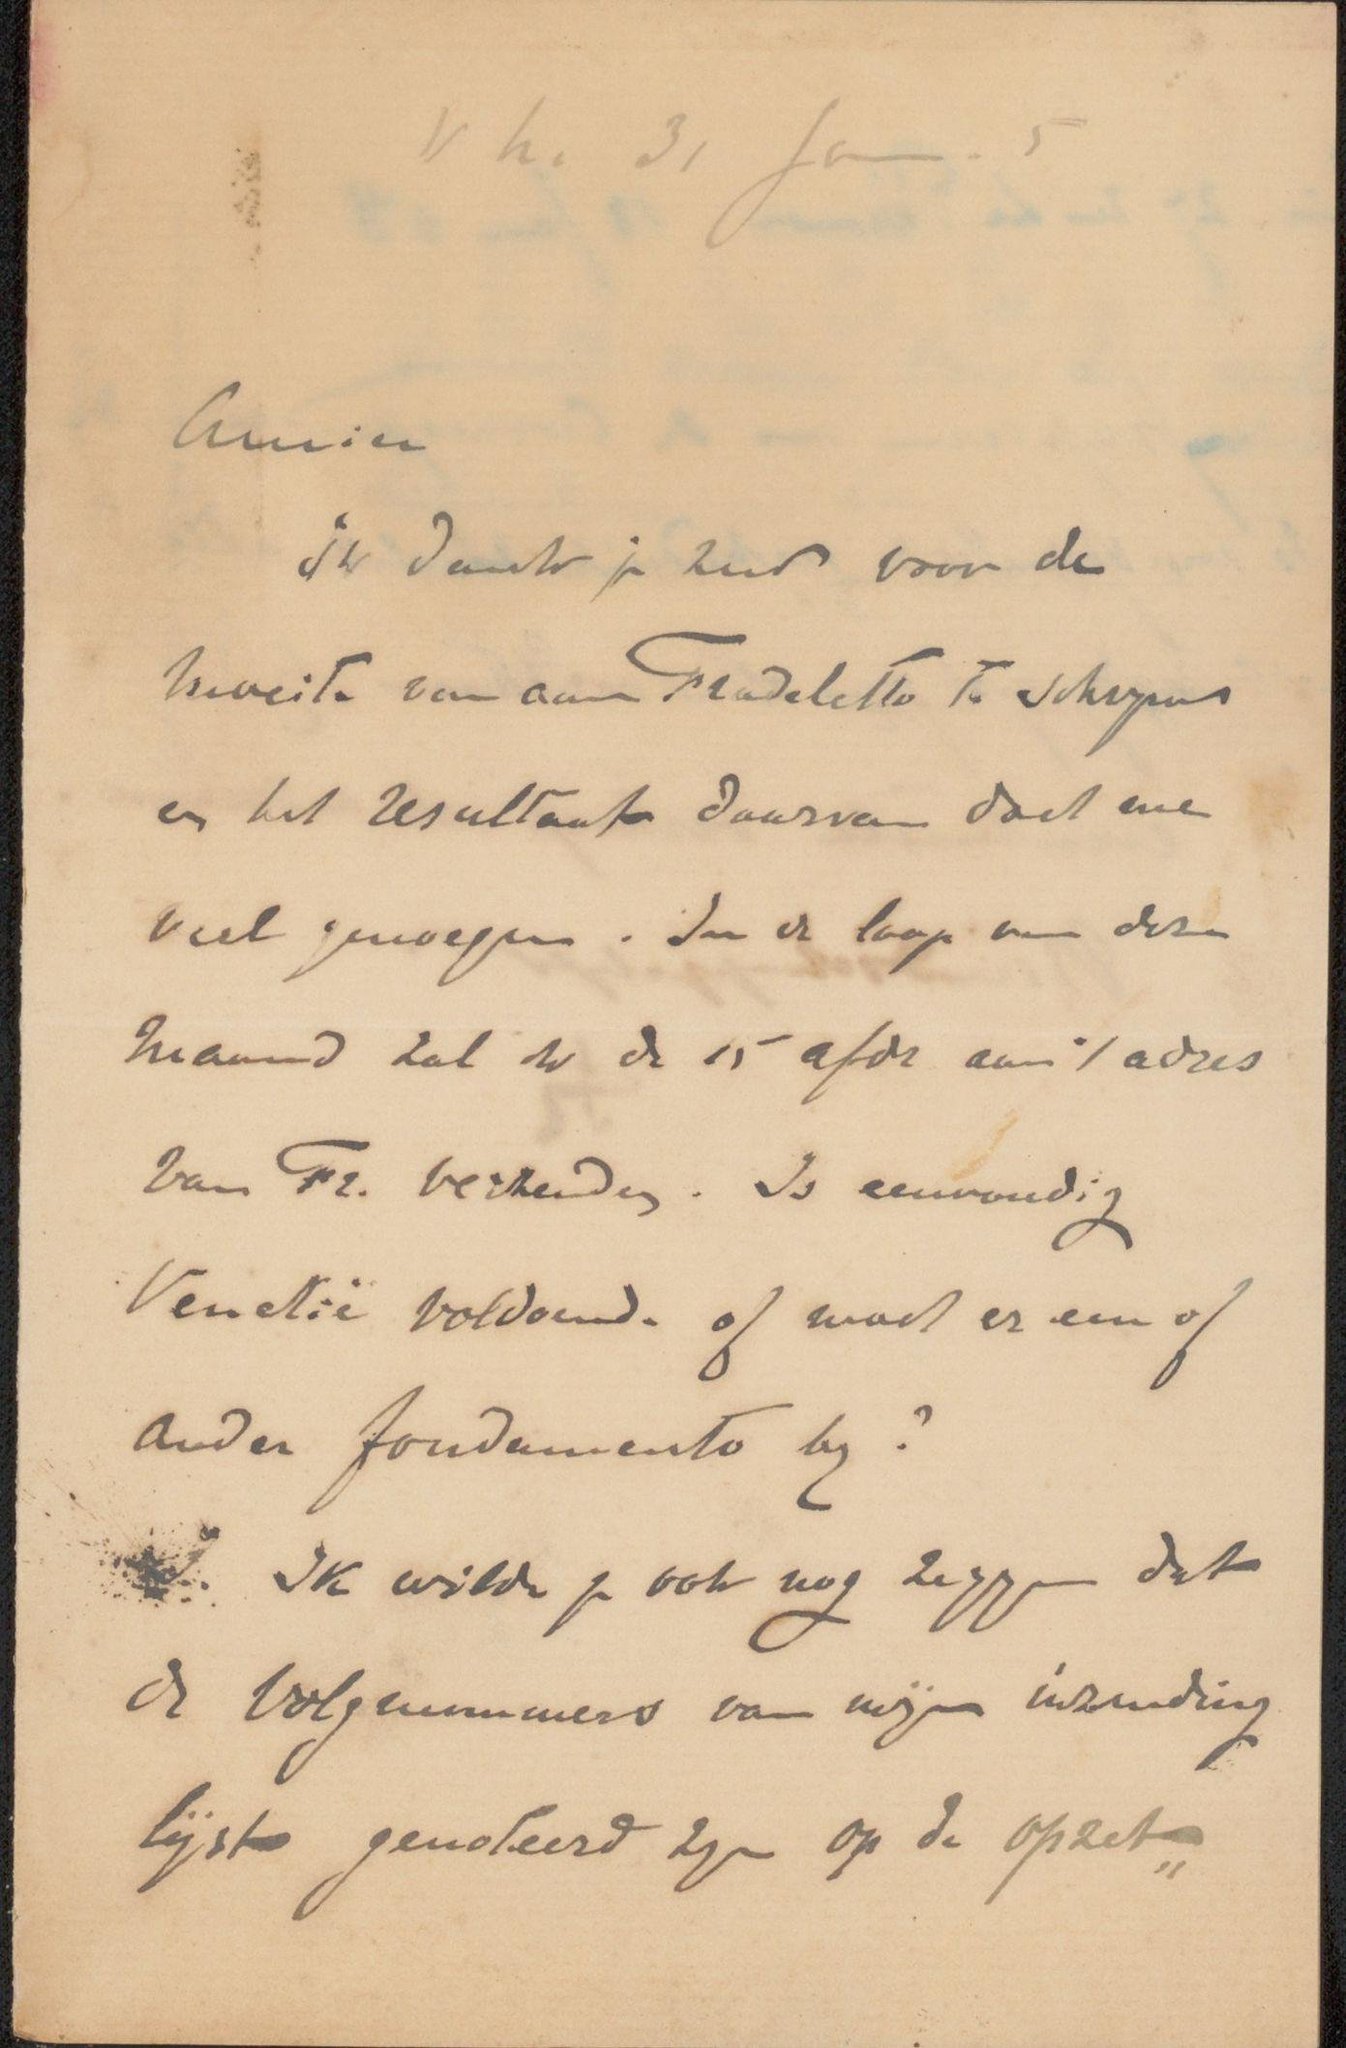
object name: letter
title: Brief aan Philip Zilcken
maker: carel nicolaas storm van s-gravesande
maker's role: draughtsman, print maker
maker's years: 1841-1924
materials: ink, paper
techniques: pen, writing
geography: the hague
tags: venice, rome, politician, antonio fradeletto, painter, philip zilcken, the graphic arts, exhibition ~ art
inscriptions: watermark, collector's mark: ‘RPK’, address: ‘DEN HAAG/ NIEUWE PARKLAAN 5./ VILLA MARGARETHA’